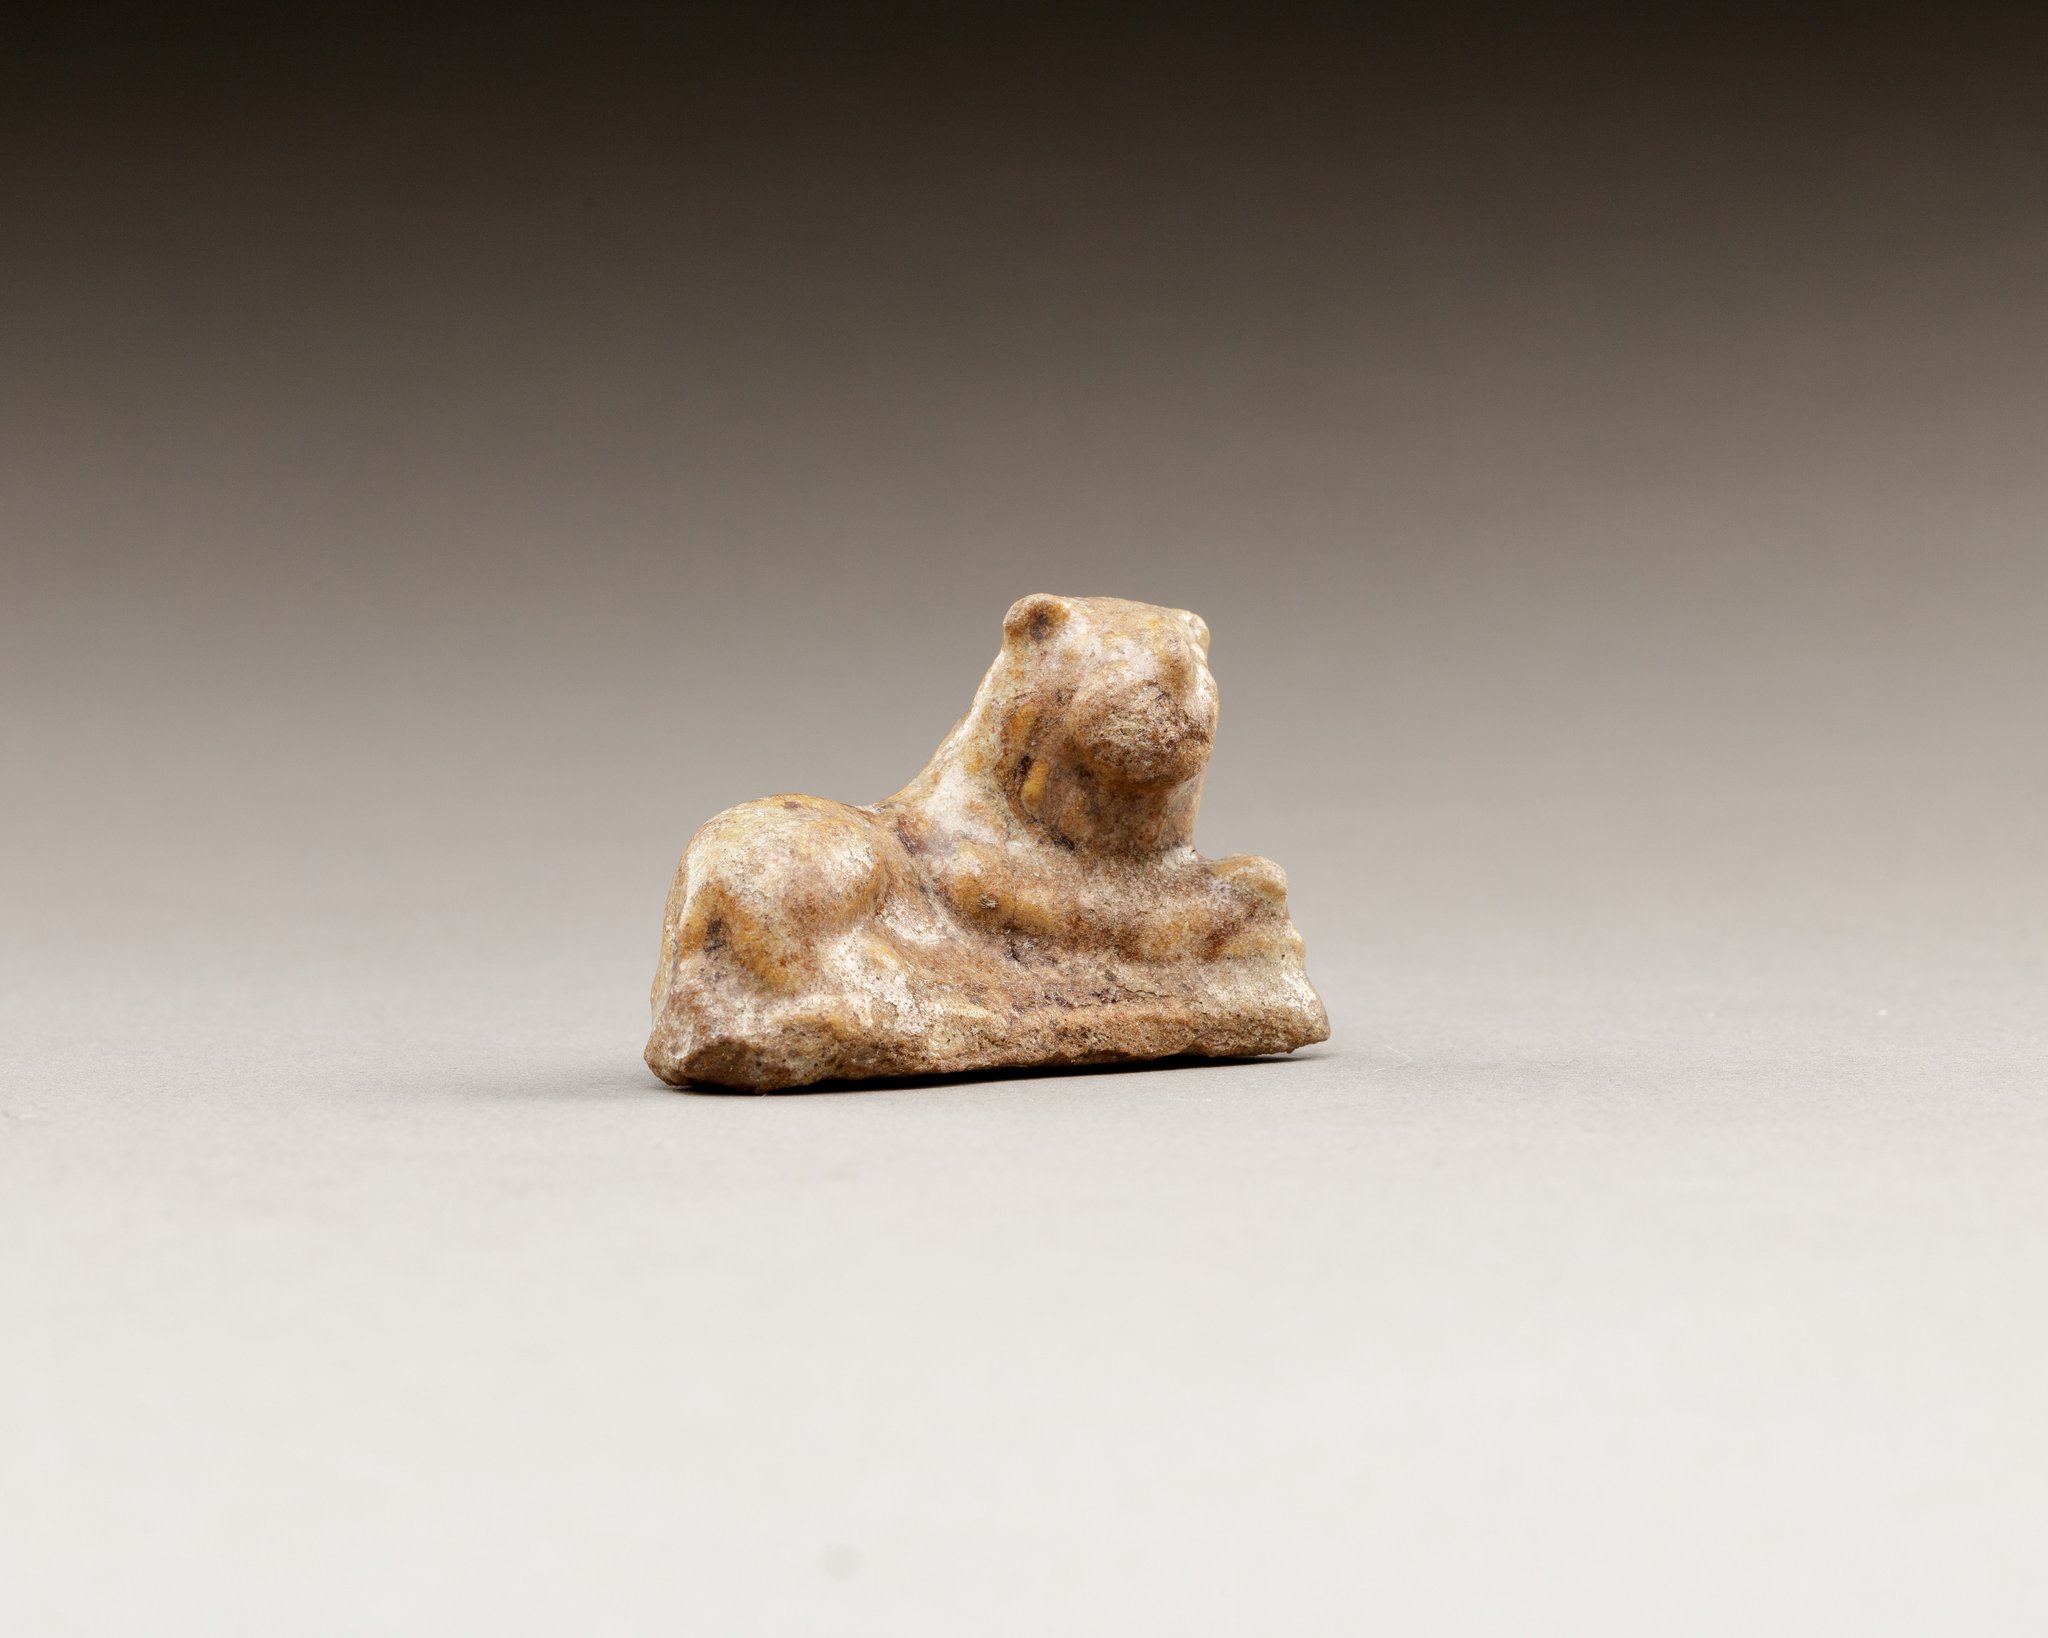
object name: figurine, lion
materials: earthenware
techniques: glazing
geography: egypt